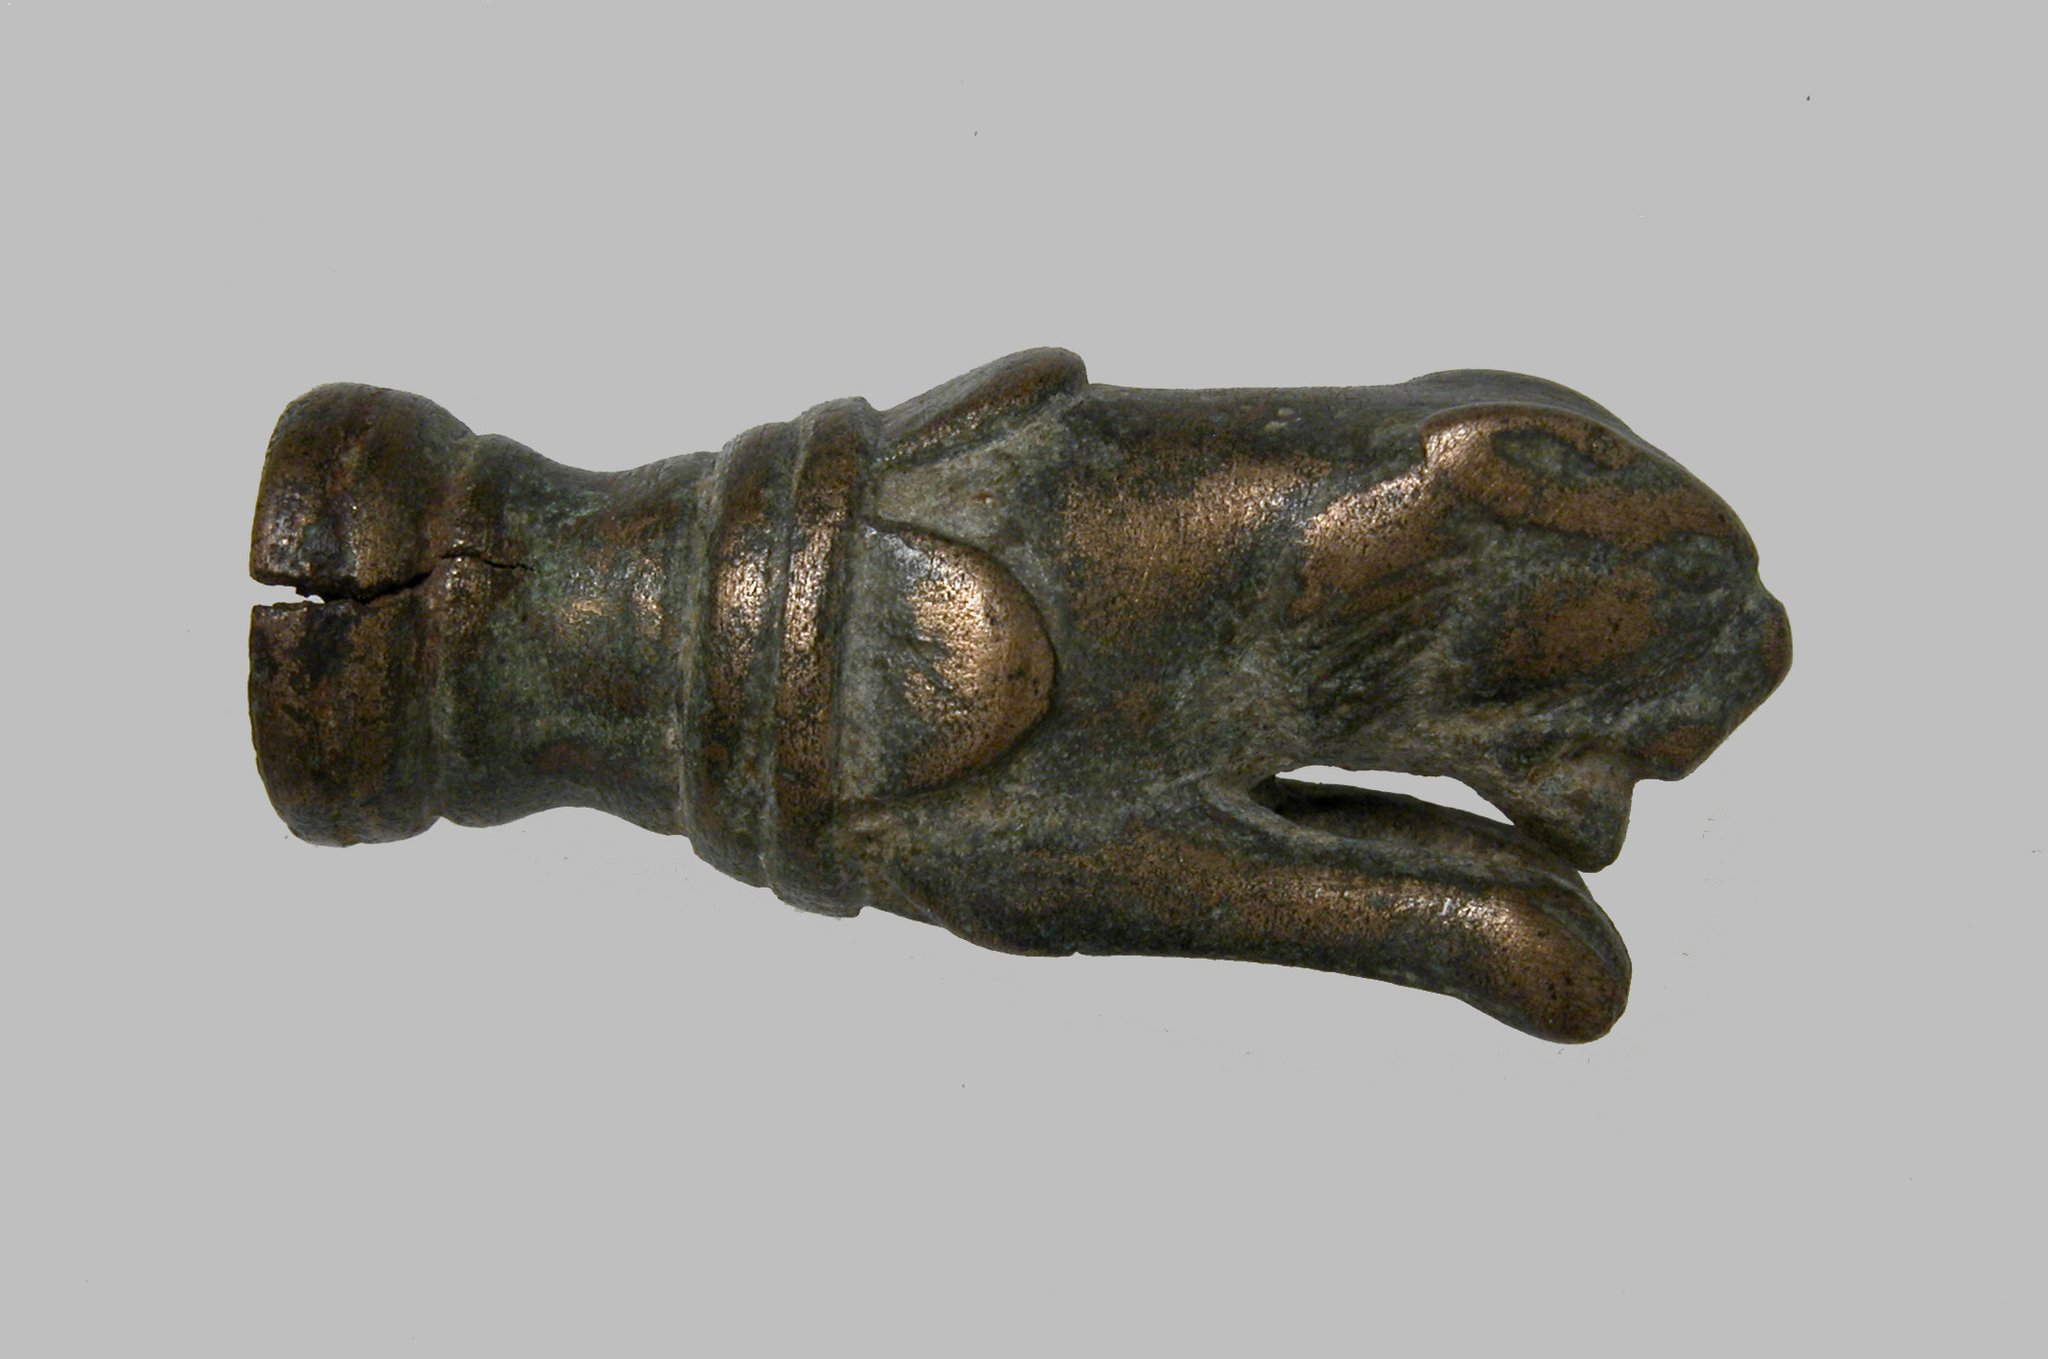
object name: key handle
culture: roman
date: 1-700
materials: copper alloy